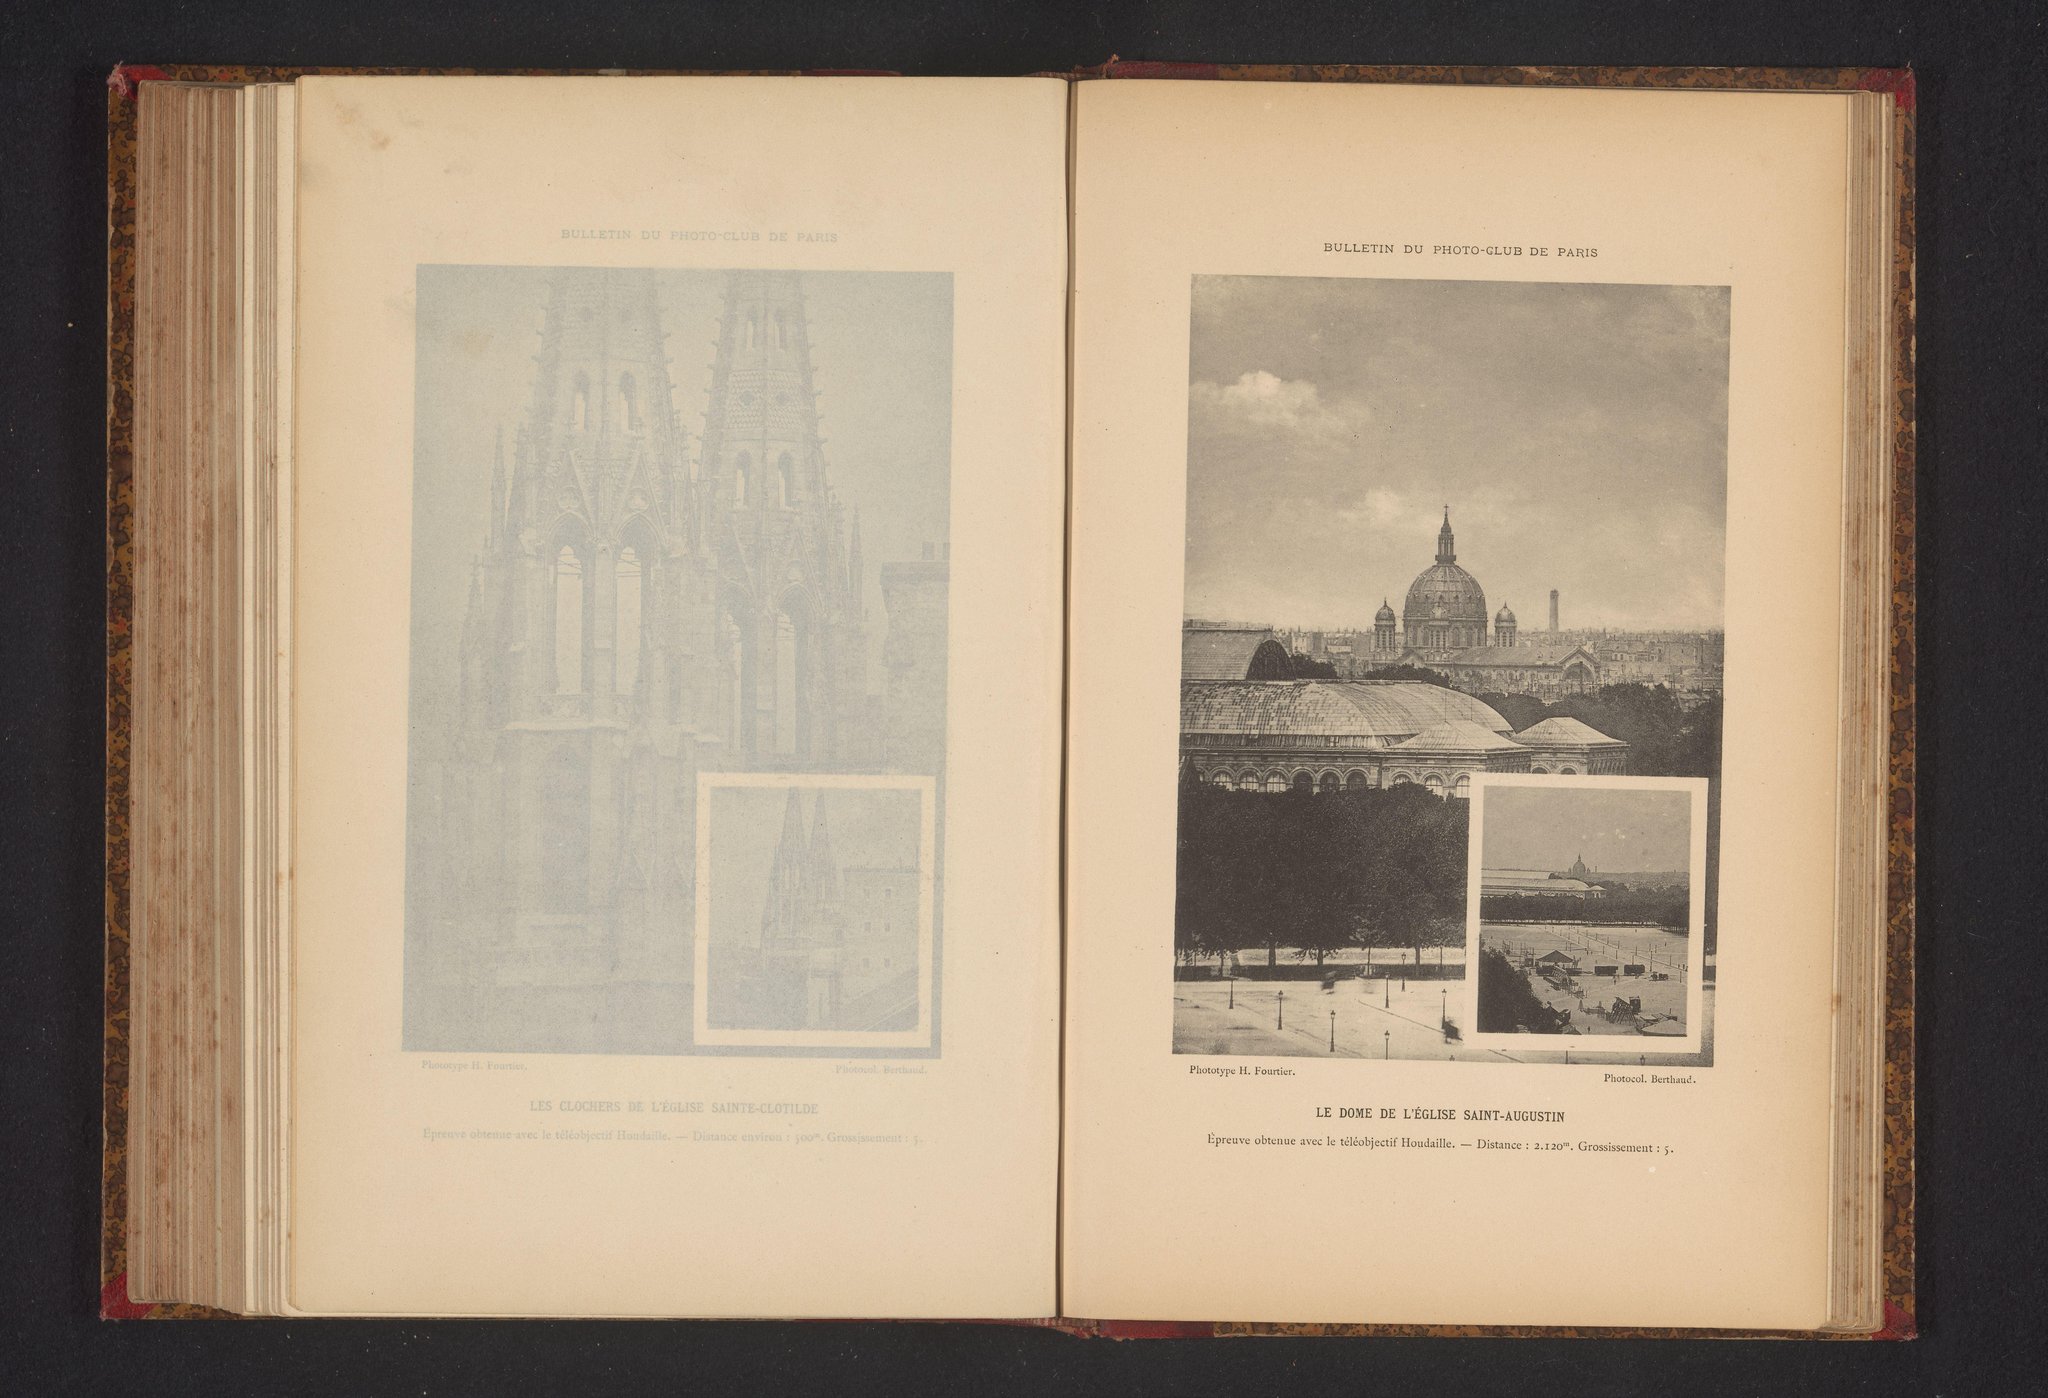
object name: page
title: Gezicht op de Sint-Augustinuskerk in Parijs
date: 1888-1893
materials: paper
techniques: photograph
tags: church (exterior), prospect of city, town panorama, silhouette of city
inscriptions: inscription: ‘Bulletin du Photo-Club de Paris’, inscription: ‘Épreuve obtenue avec le téléobjectif Houdaille. - Distance : 2.120m. Grossissement : 5.’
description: Prent op derde ongenummerde pagina na pagina 332.